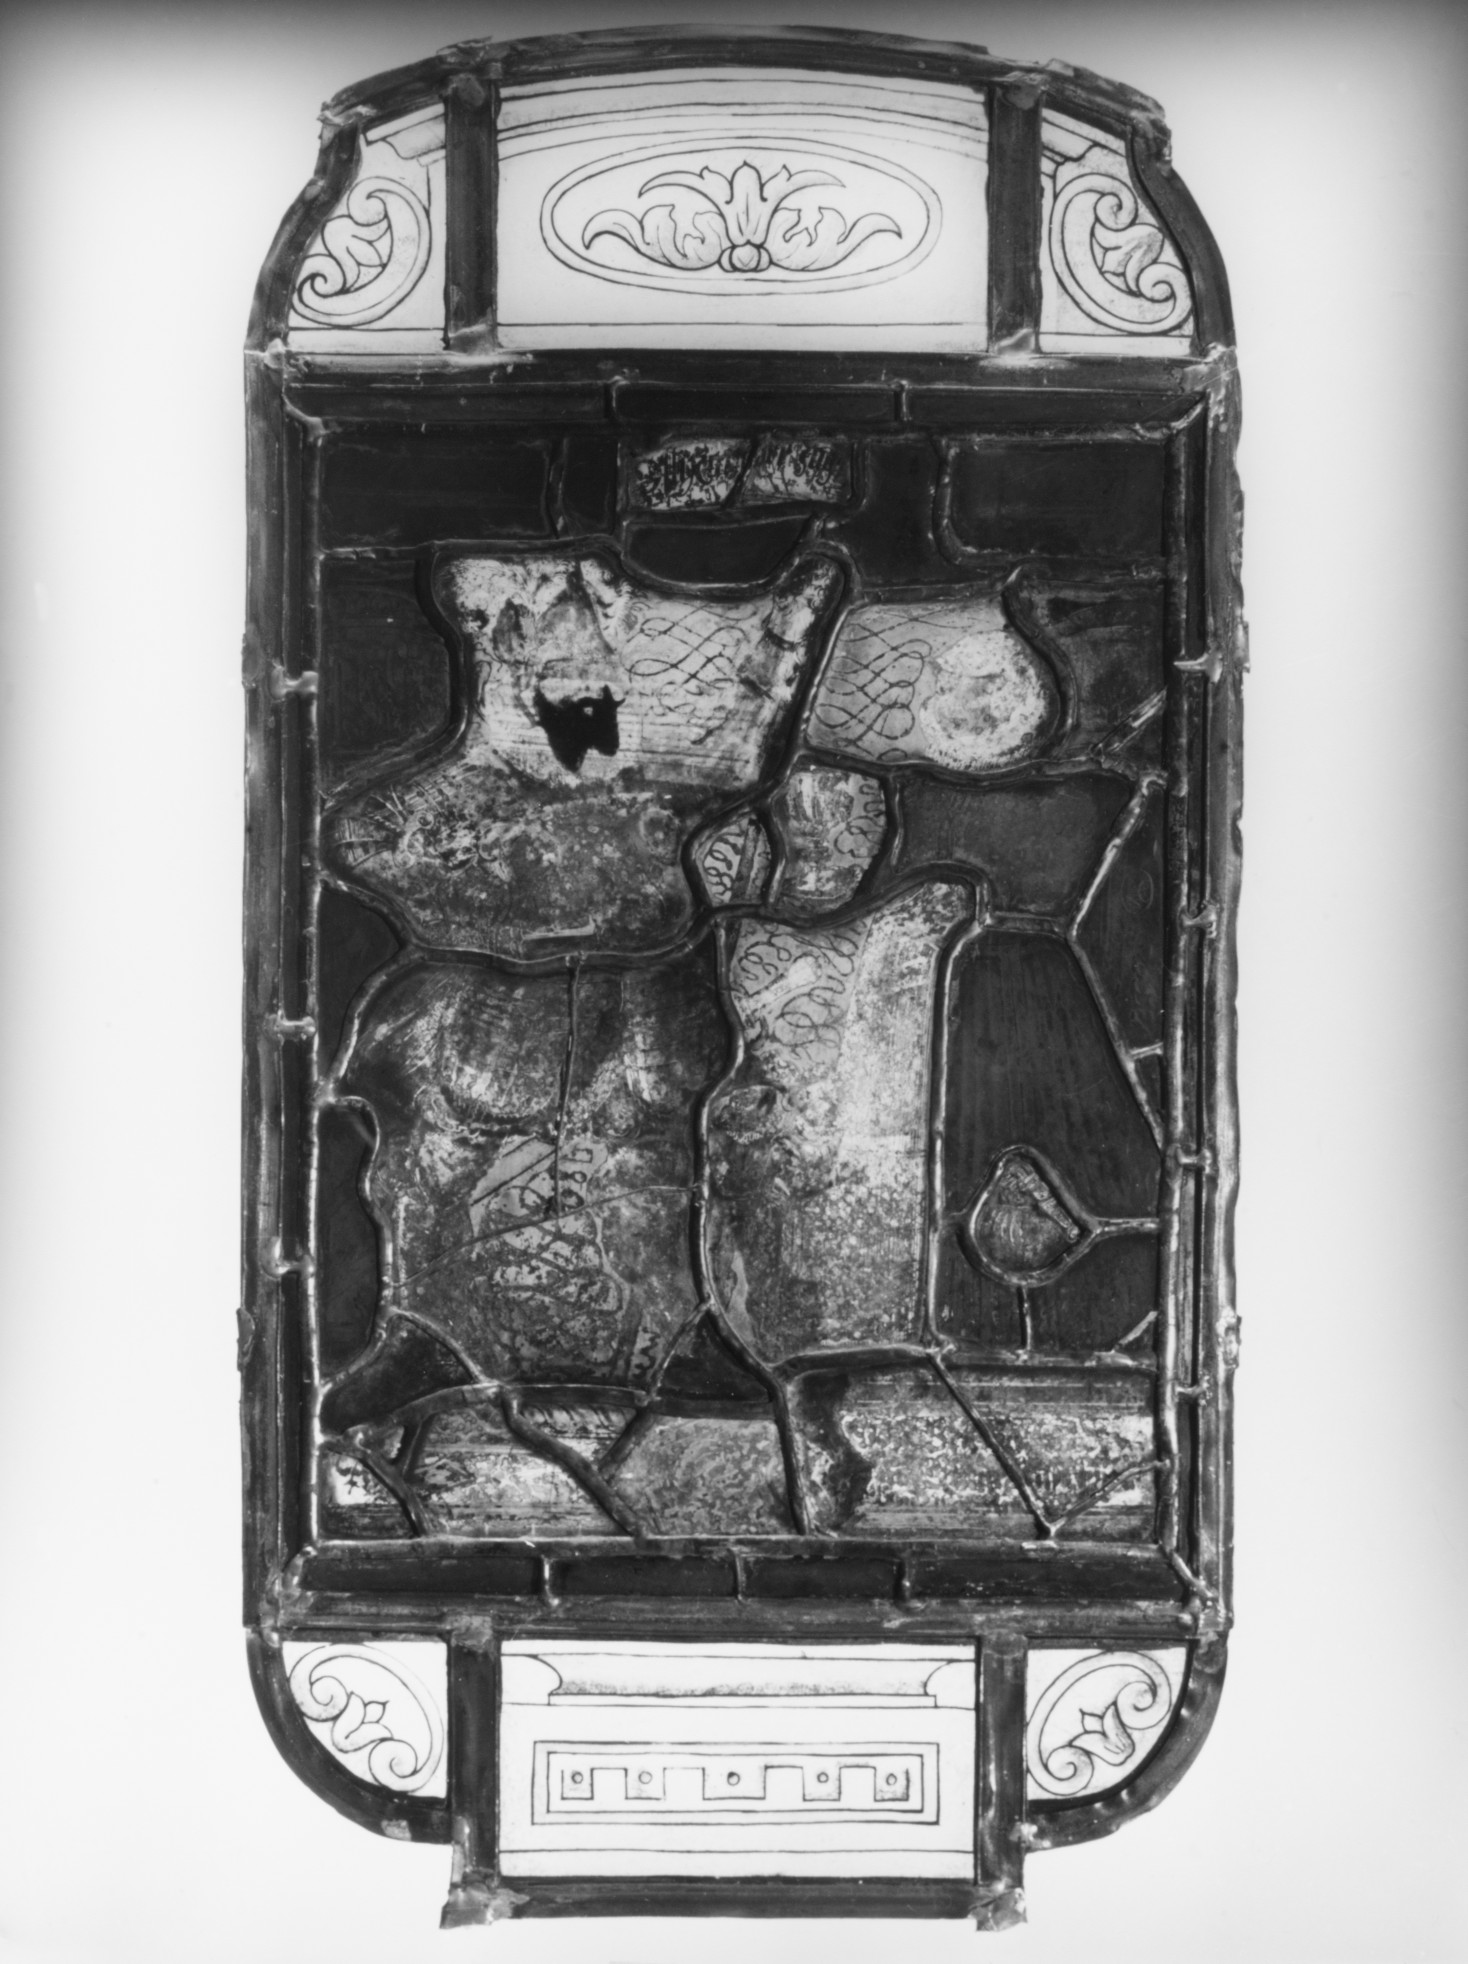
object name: panel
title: Woman and Warrior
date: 1601-1633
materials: glass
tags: women